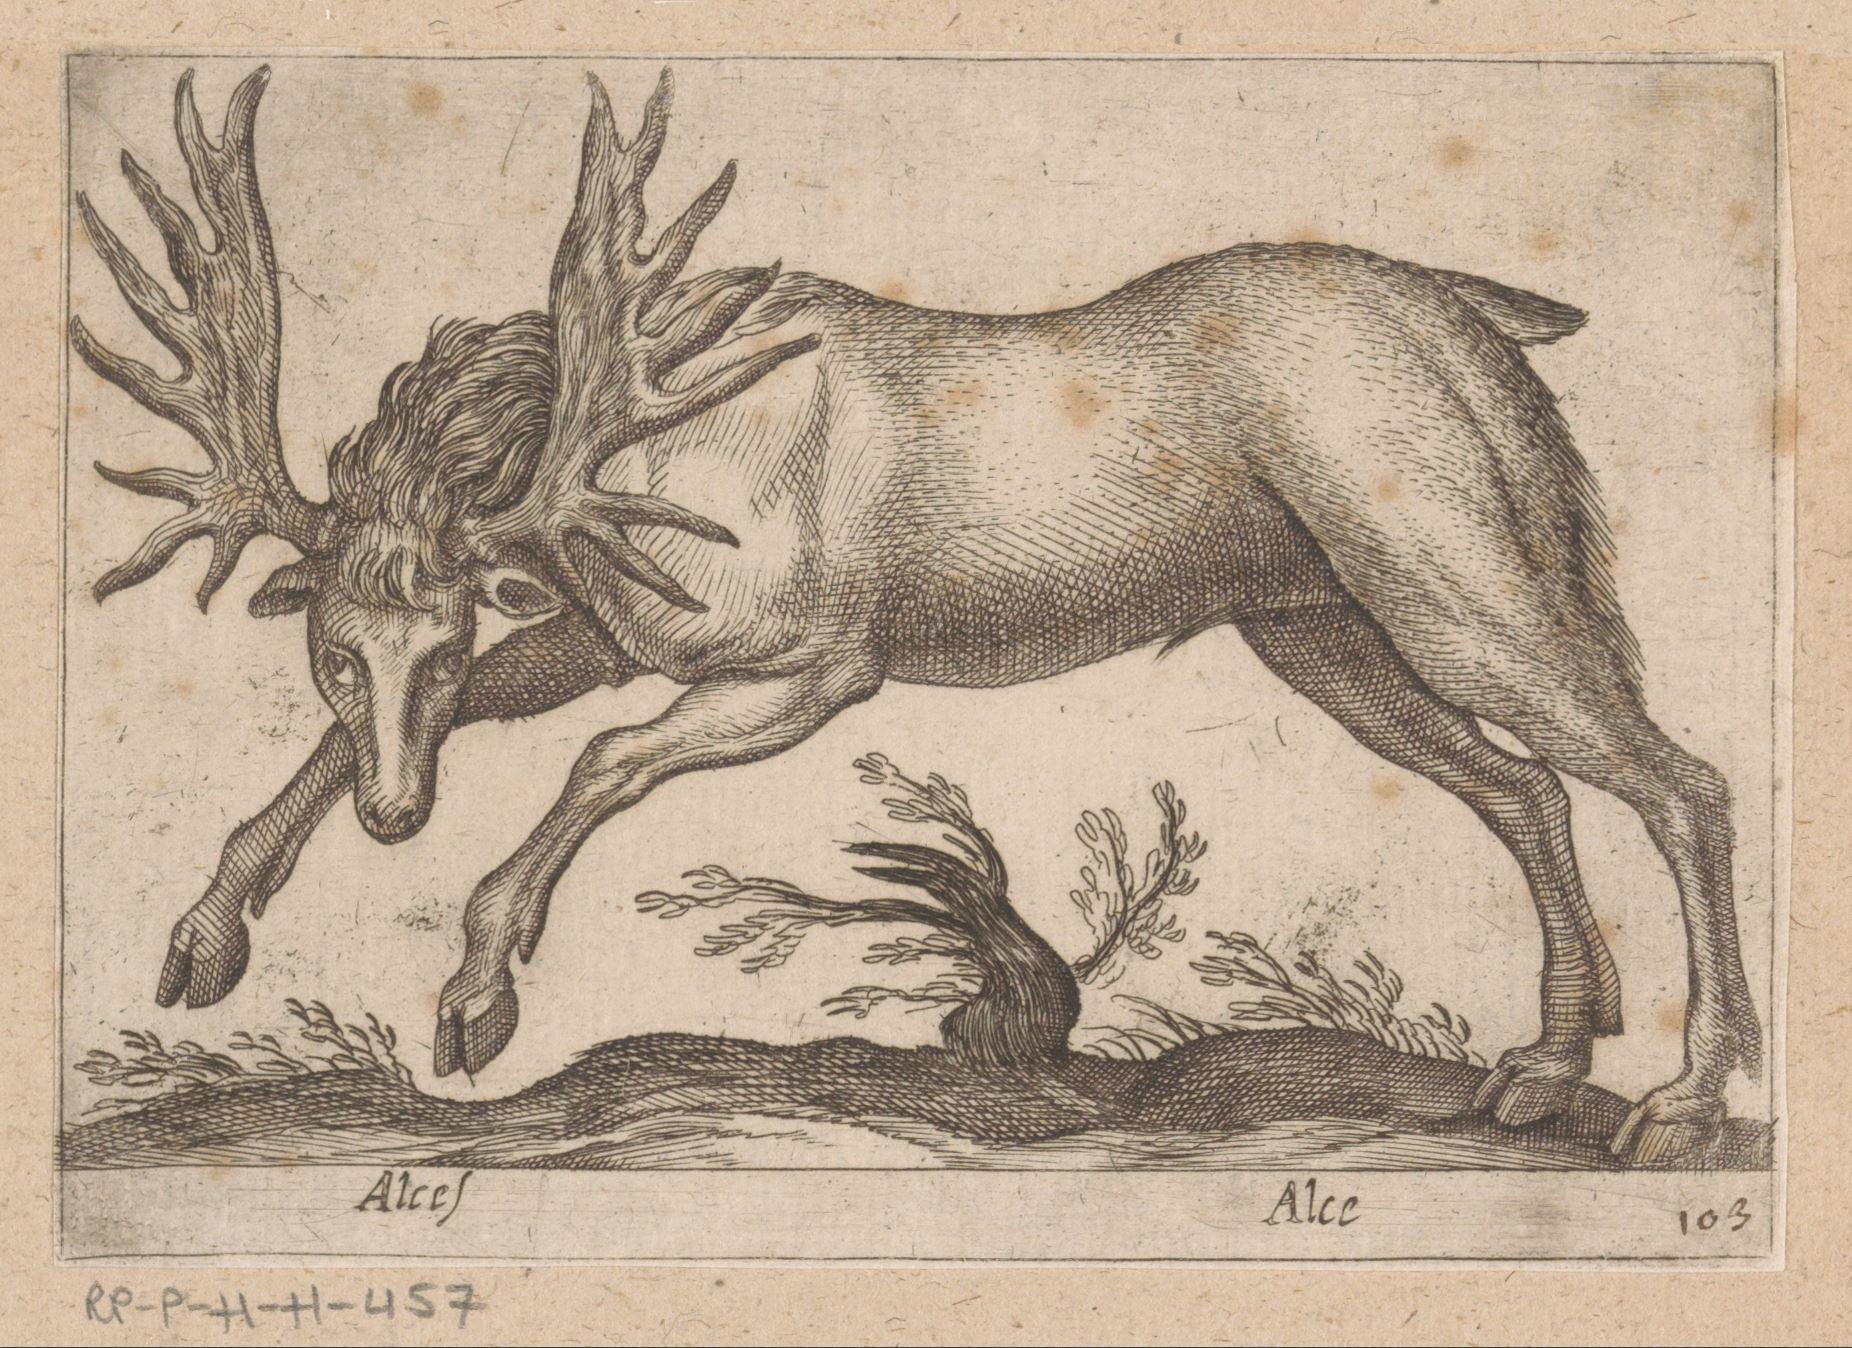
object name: print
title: Nova raccolta de li animali piu curiosi del mondo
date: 1565-1630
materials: paper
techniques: etching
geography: vatican city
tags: hoofed animals: elk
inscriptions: collector's mark: Lugt 11, number: ‘103’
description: Deze prent maakt deel uit van een reeks prenten van dieren door Antonio Tempesta. Bekend is dat een tweede staat (met nummering) van deze serie is uitgegeven door Giovanni Giacomo de' Rossi in 1650. Onbekend is wie de eerste staat heeft uitgegeven en wanneer.